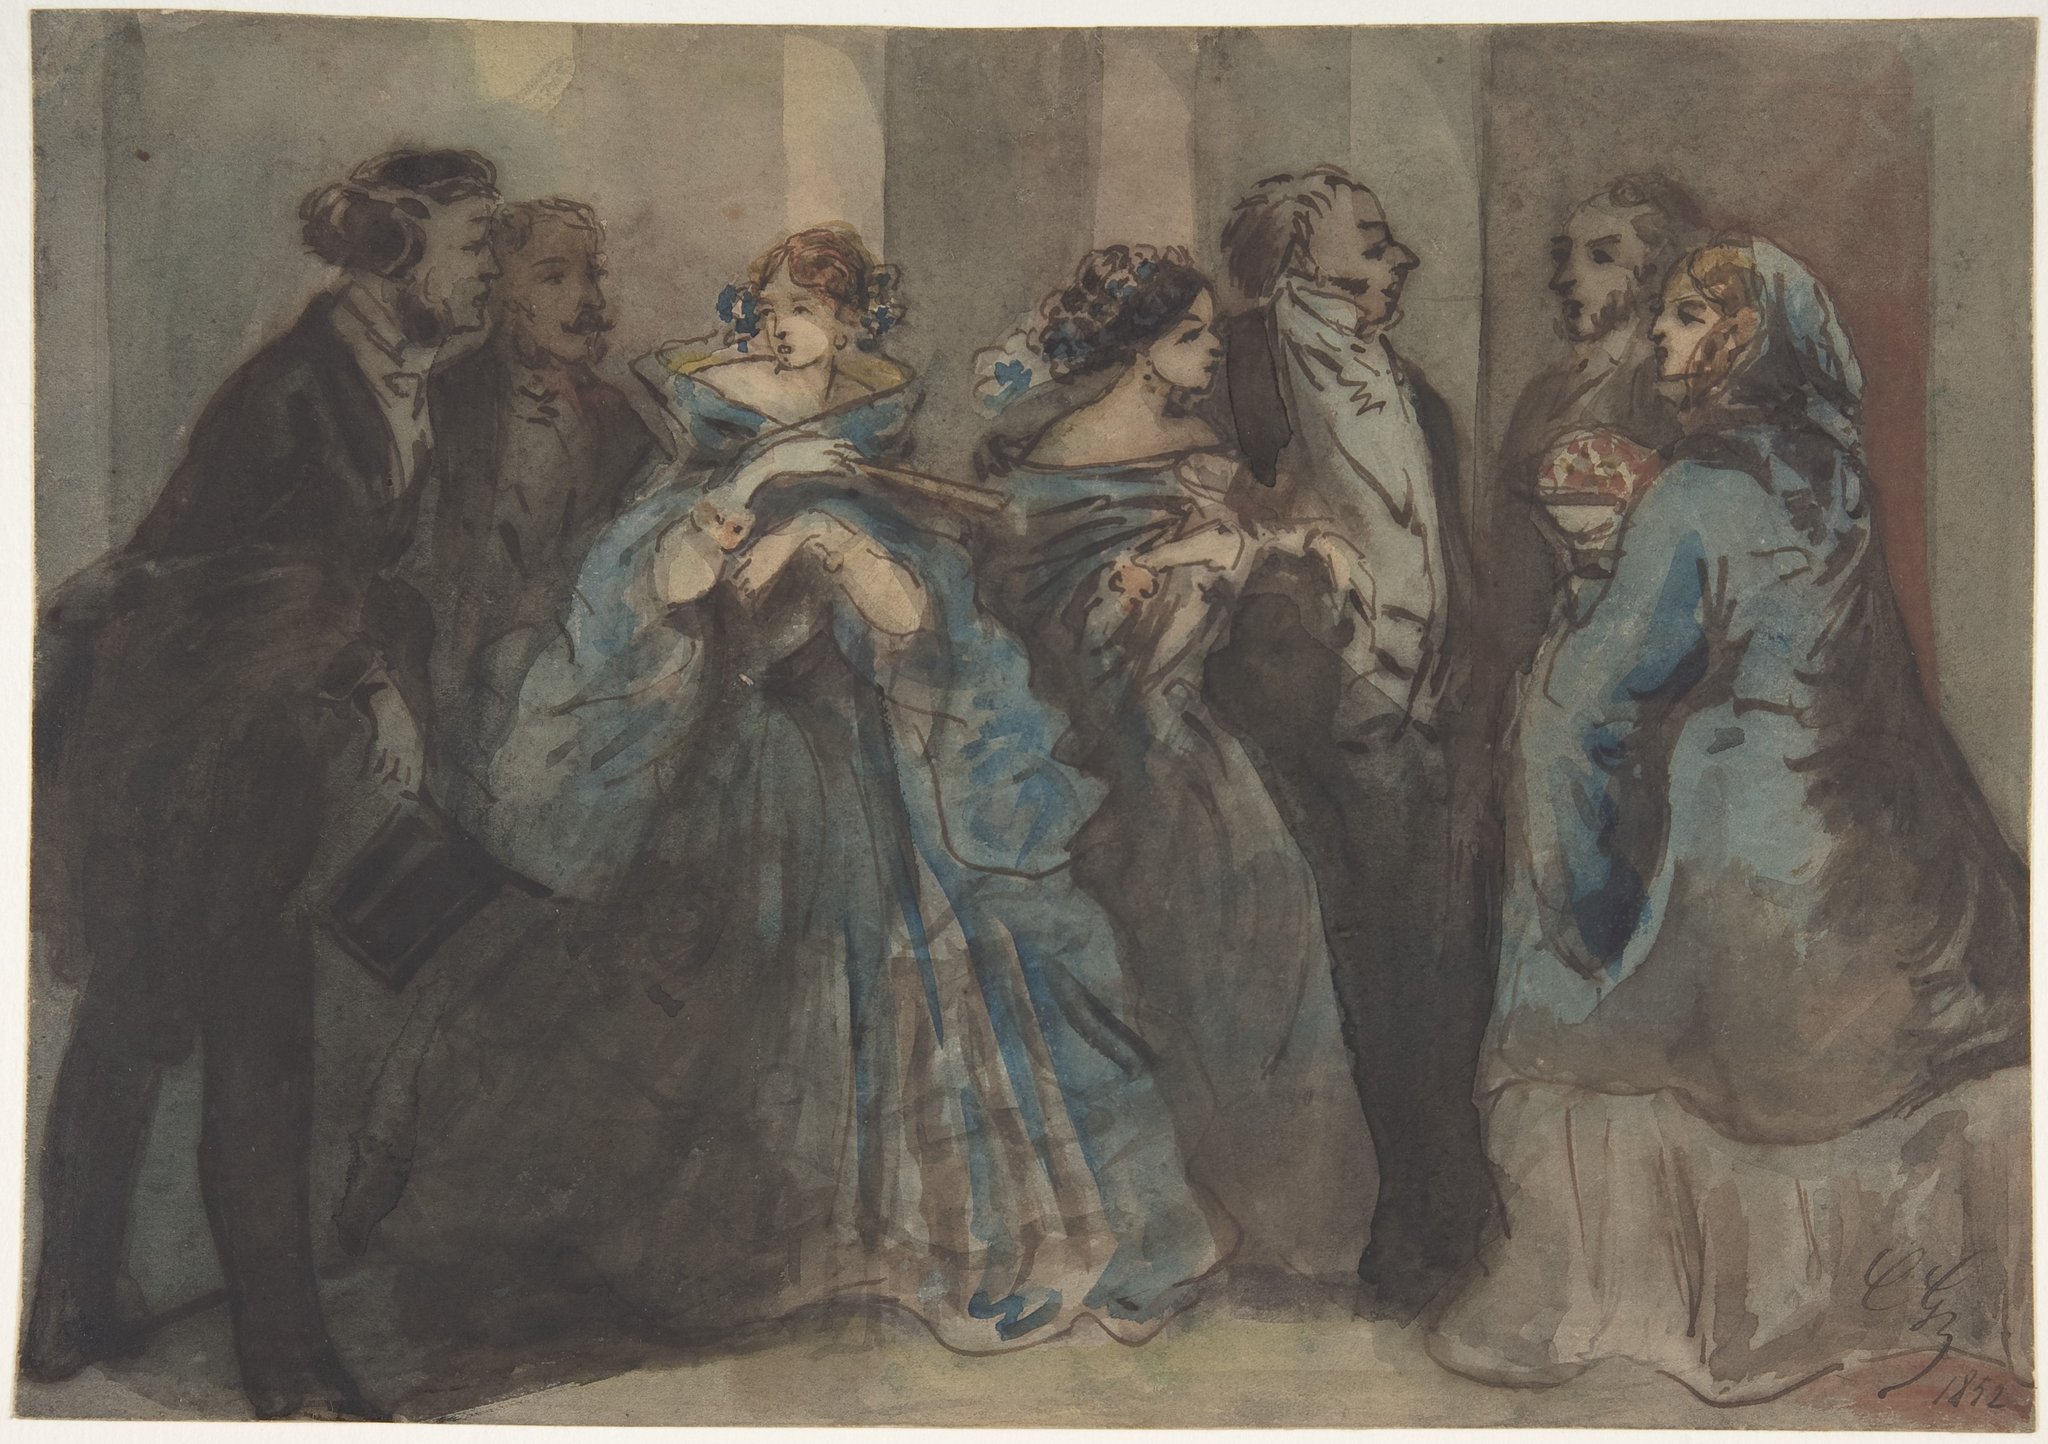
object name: drawing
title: Leaving the Theater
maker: constantin guys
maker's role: artist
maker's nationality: french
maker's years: 1802-1892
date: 1801-1900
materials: ink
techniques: brush, pen, wash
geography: france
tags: men,women